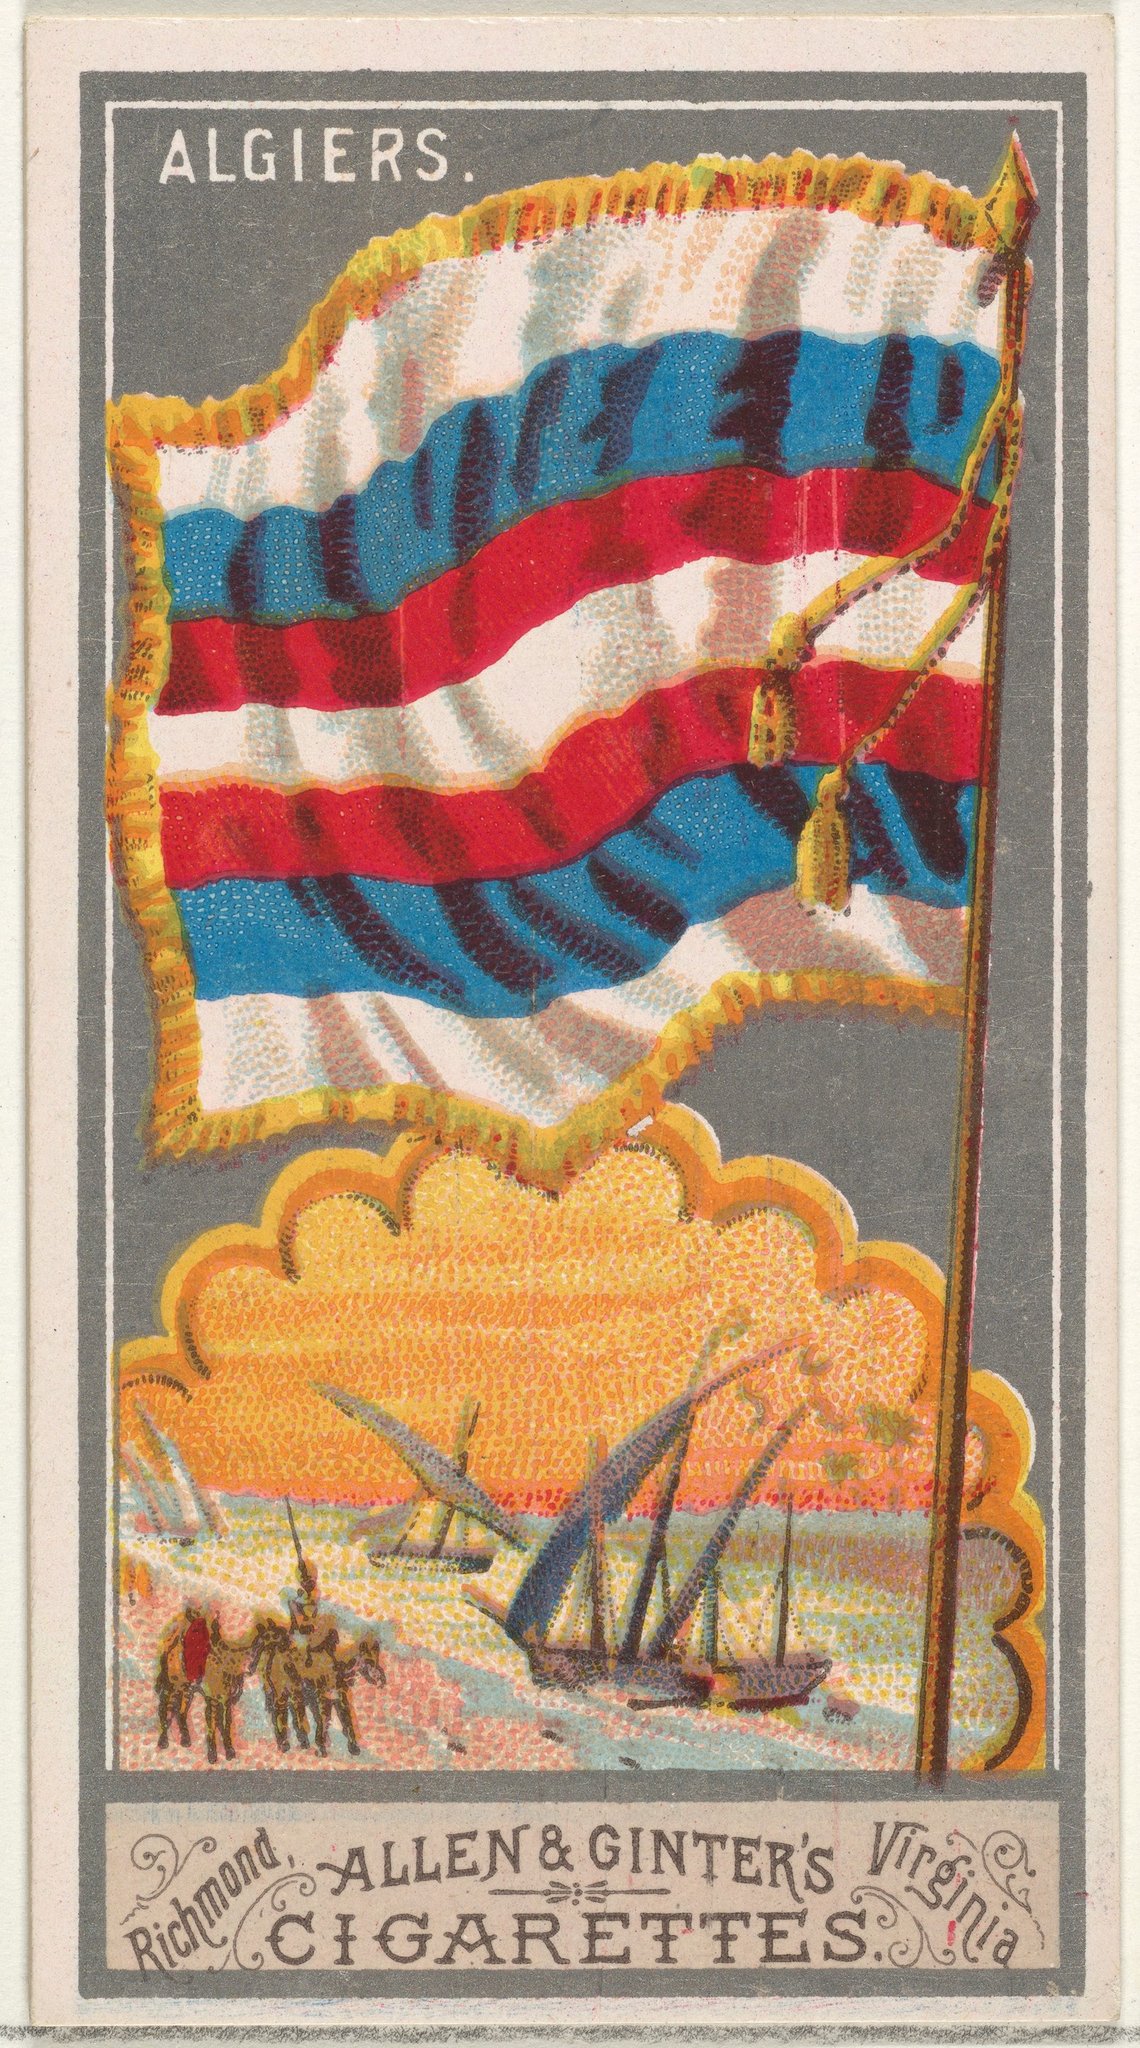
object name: print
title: Algiers, from the City Flags series (N6) for Allen & Ginter Cigarettes Brands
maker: allen & ginter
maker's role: publisher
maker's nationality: american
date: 1887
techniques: color lithograph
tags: flags